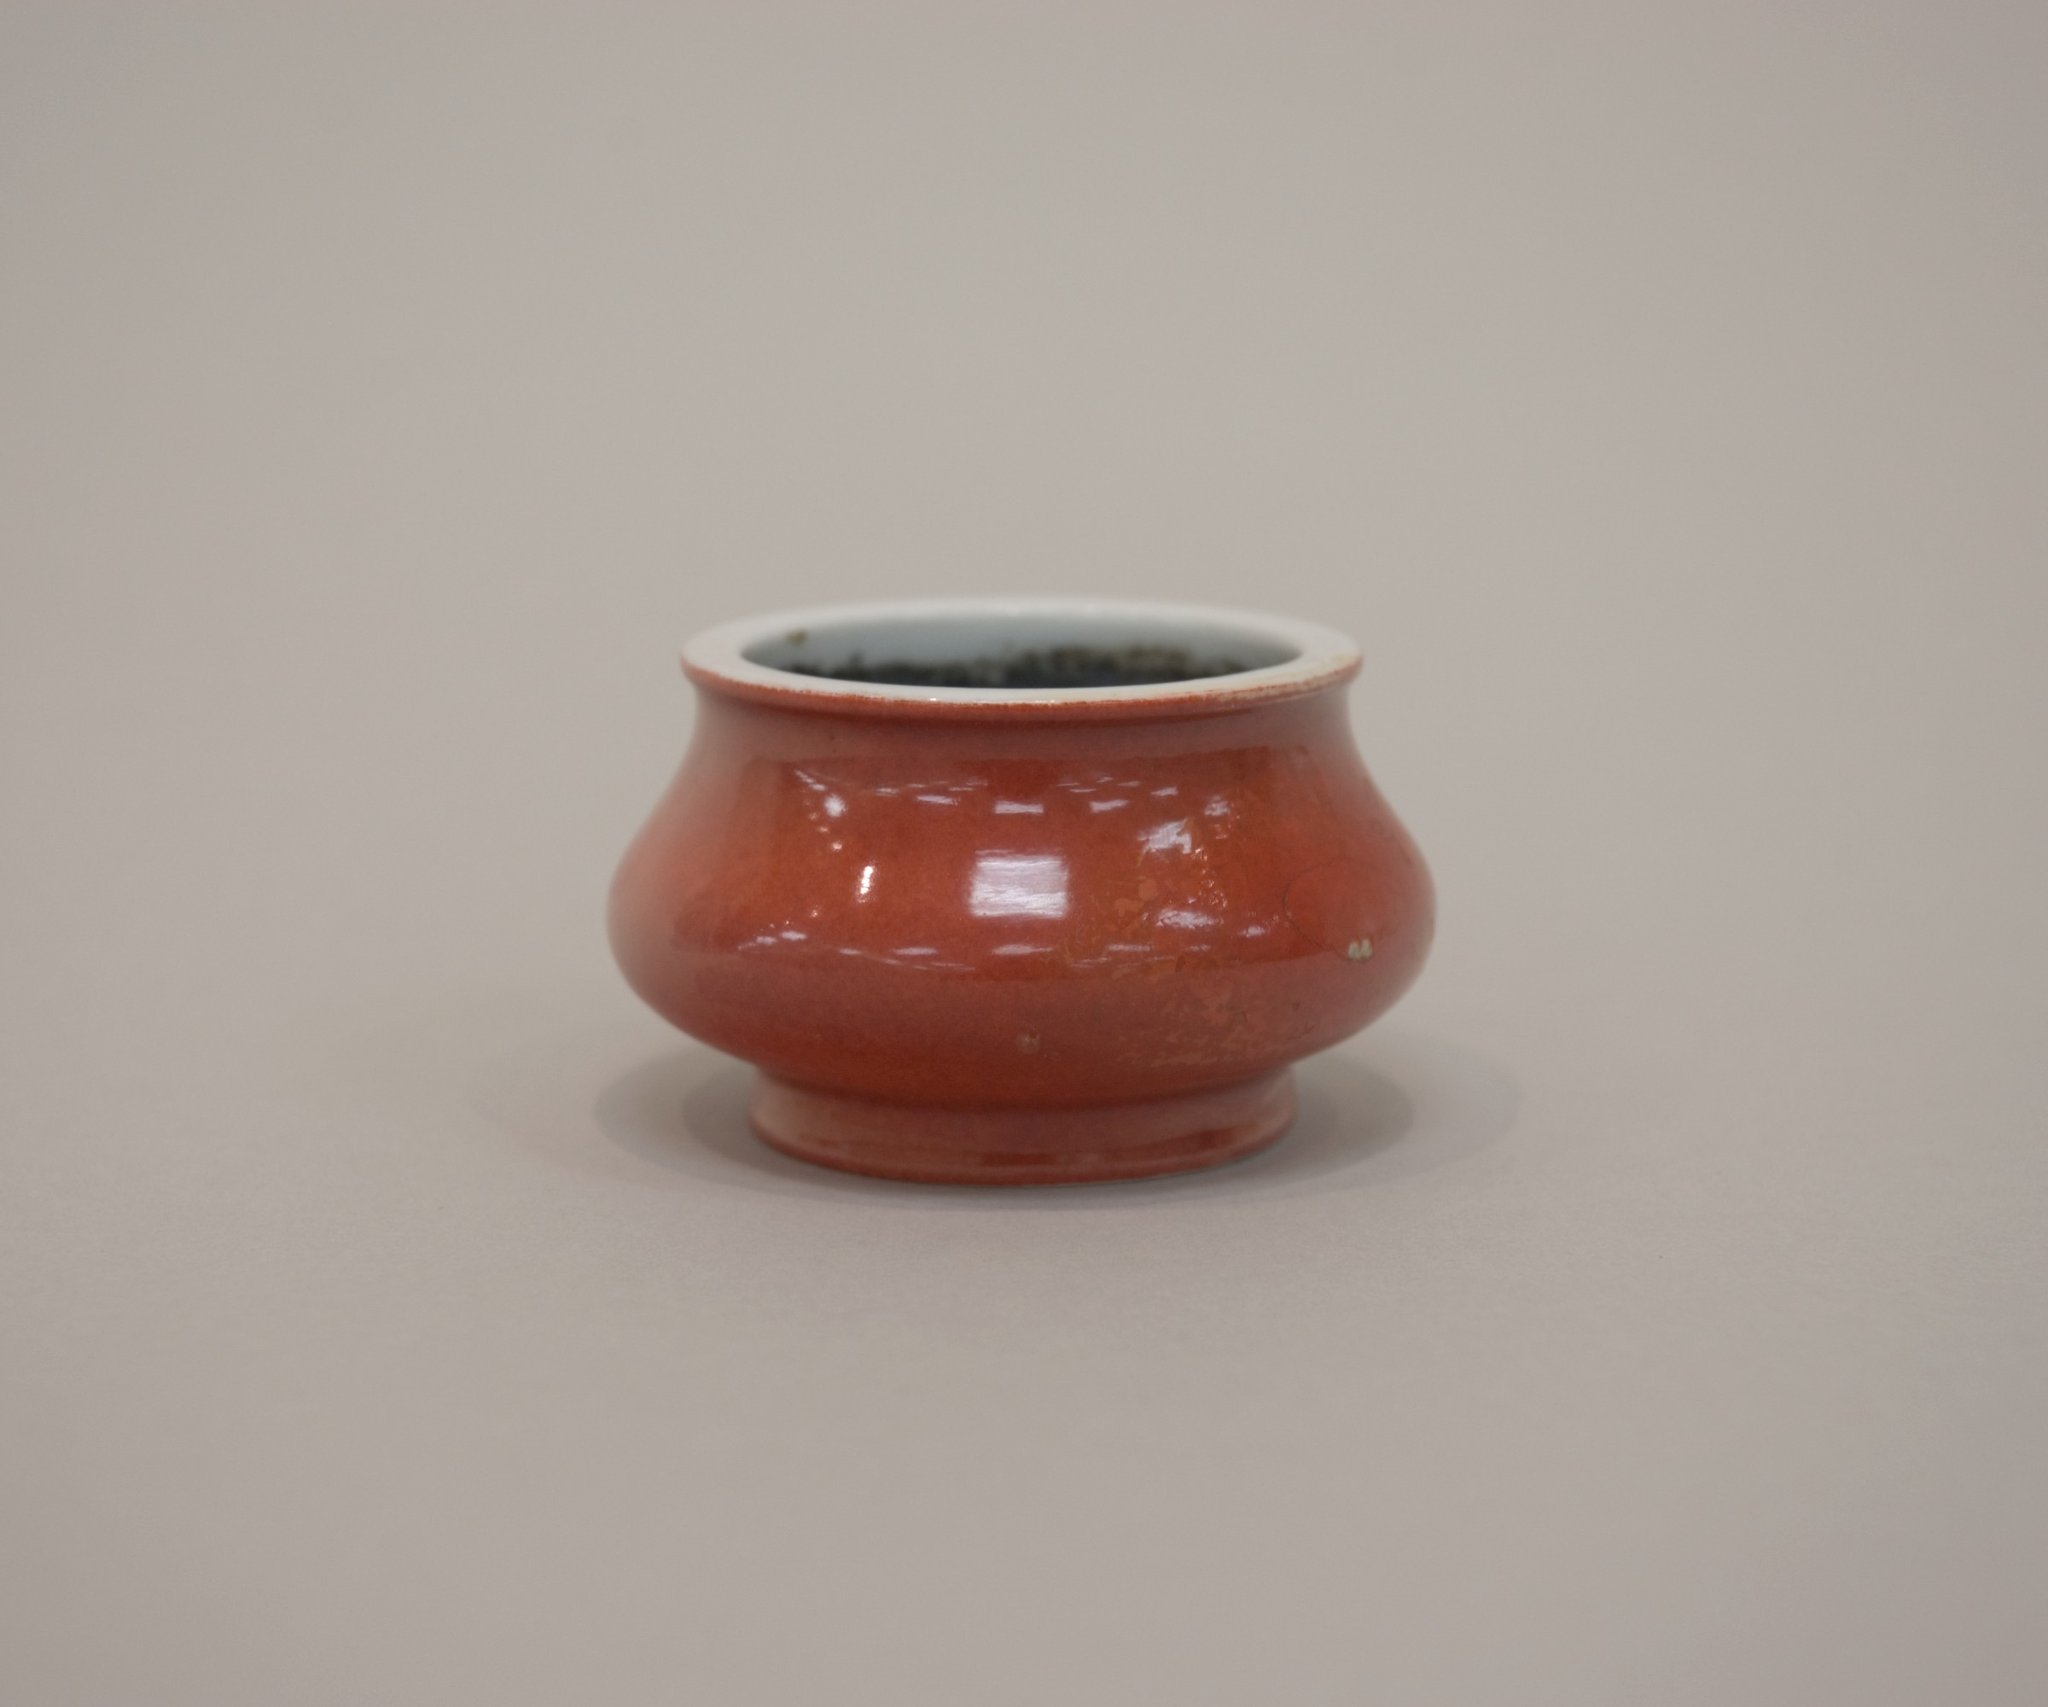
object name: incense burner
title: Minature incense burner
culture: chinese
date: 1767-1800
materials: coral, glaze, porcelain